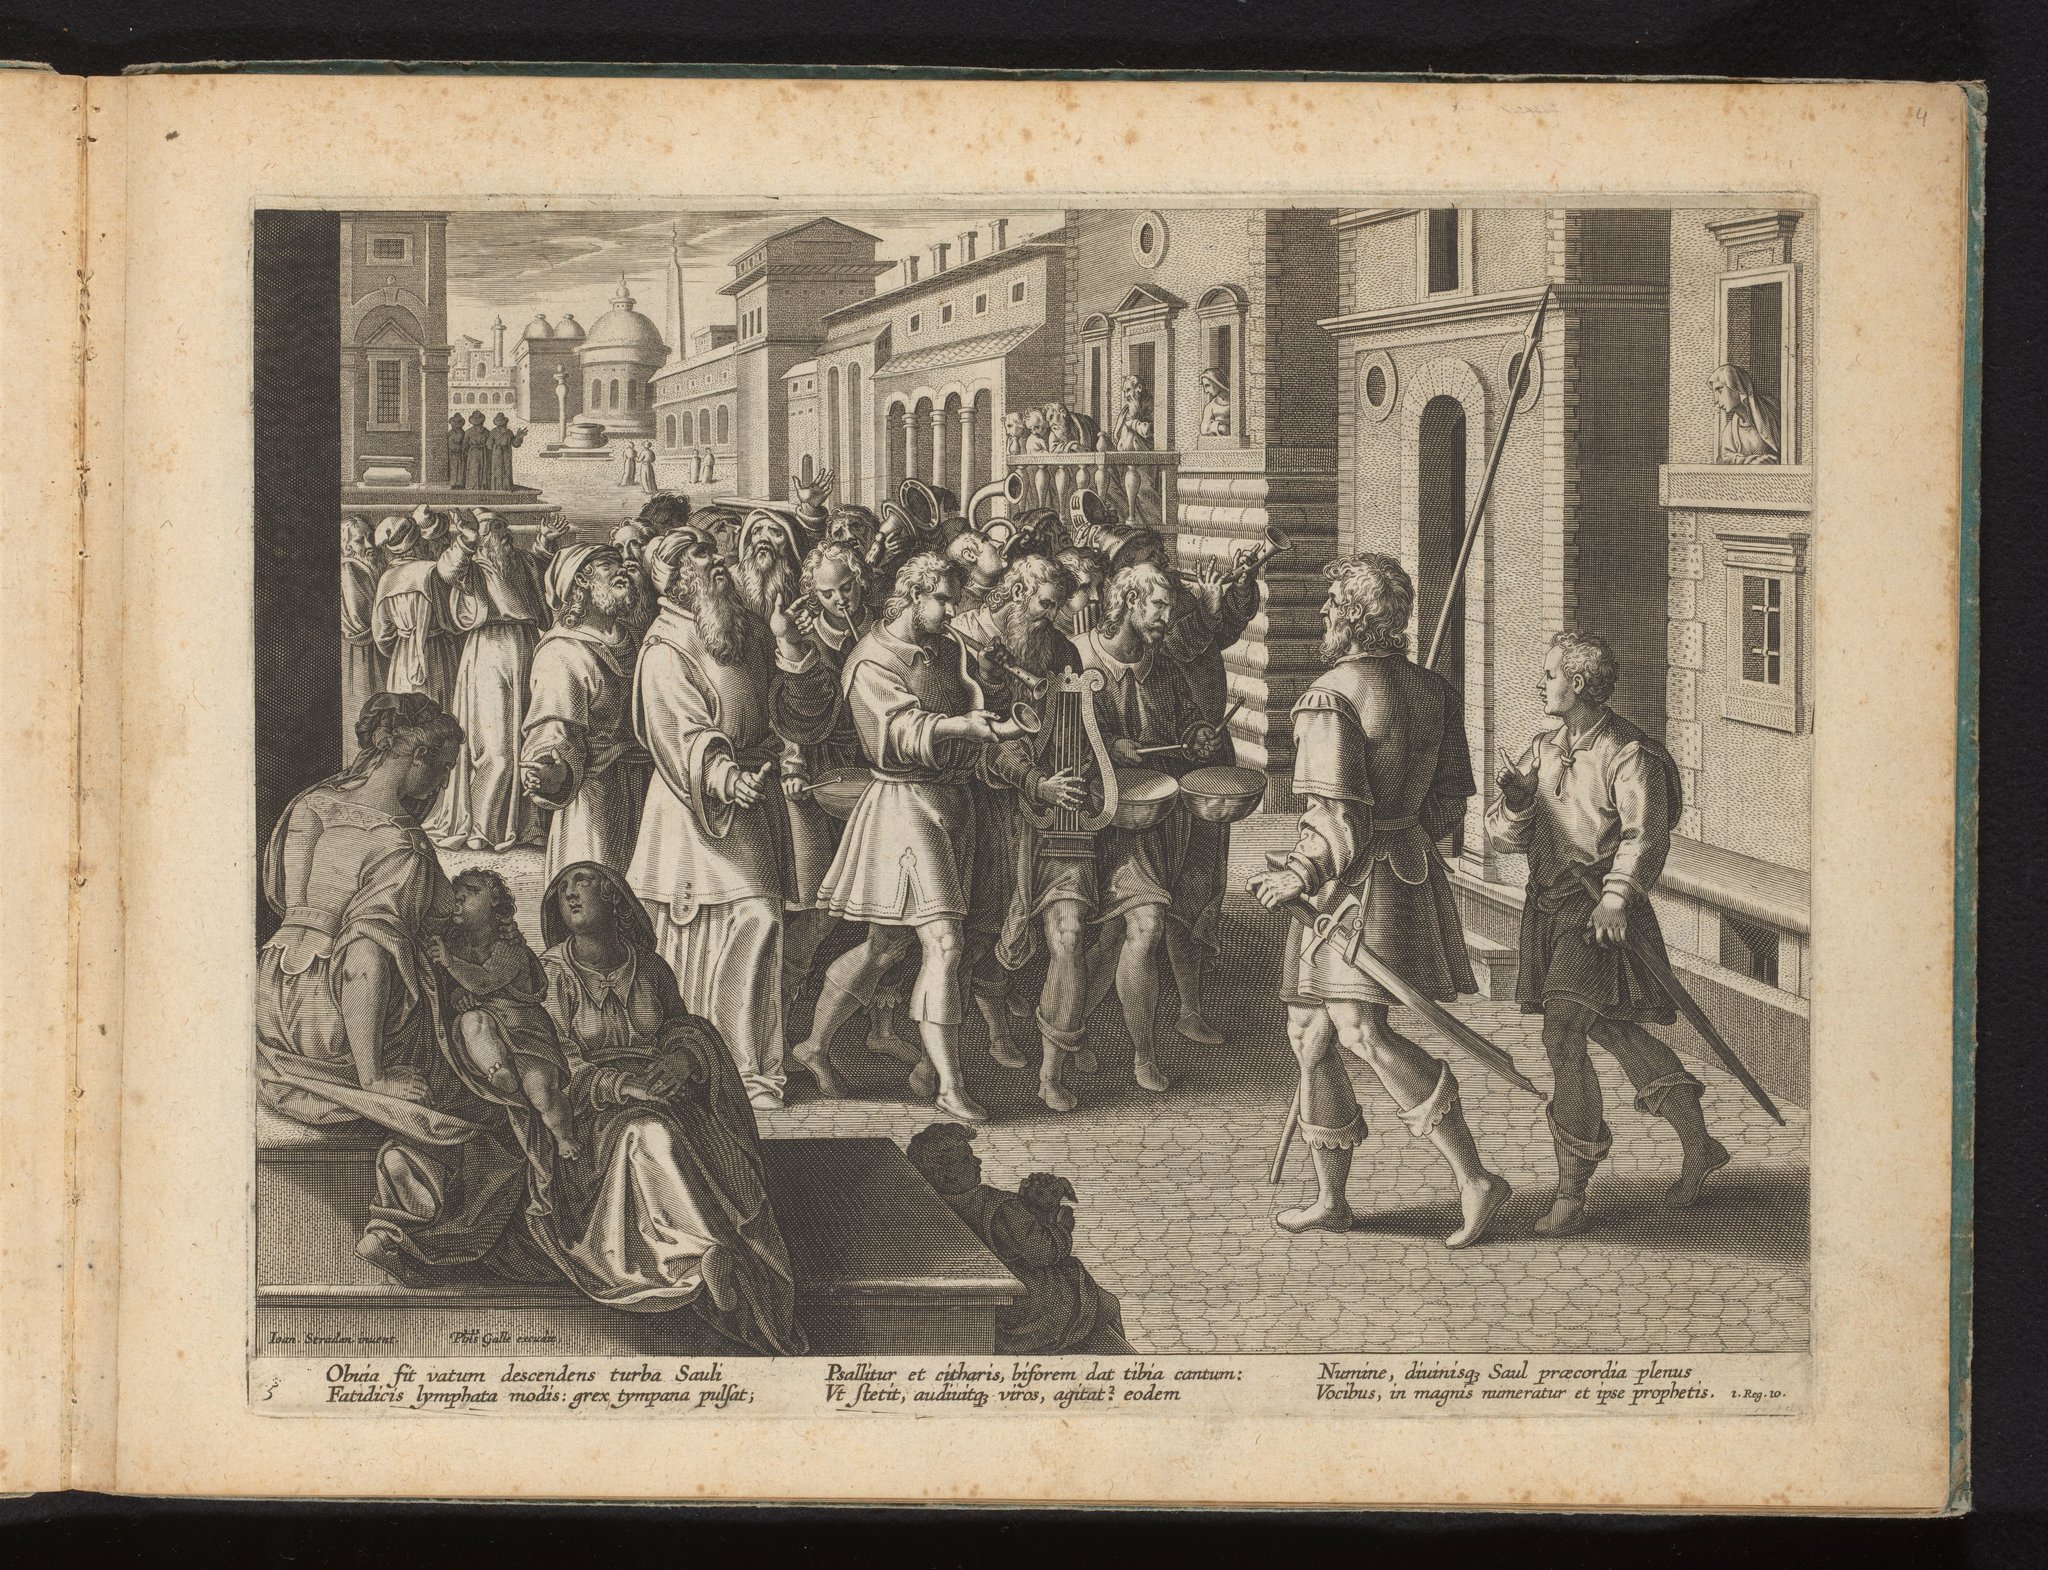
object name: print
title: Encomium musices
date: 1587-1592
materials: paper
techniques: engraving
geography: antwerp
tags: musical instruments; group of musical instruments, saul meets a group of prophets playing harps, drums, flutes and lyres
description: In de buurt van de stad Gibea-Elohim komt Saul een stoet profeten tegen die in vervoering van de offerhoogte afdalen. Ze worden voorafgegaan door muzikanten met fluiten, bazuinen, pauken en harpen. Onder invloed van de muziek zal Saul een ander mens worden. De prent heeft een Latijns onderschrift. Rechtsonder een verwijzing naar 1 Samuël 10. De prent maakt deel uit van een album.